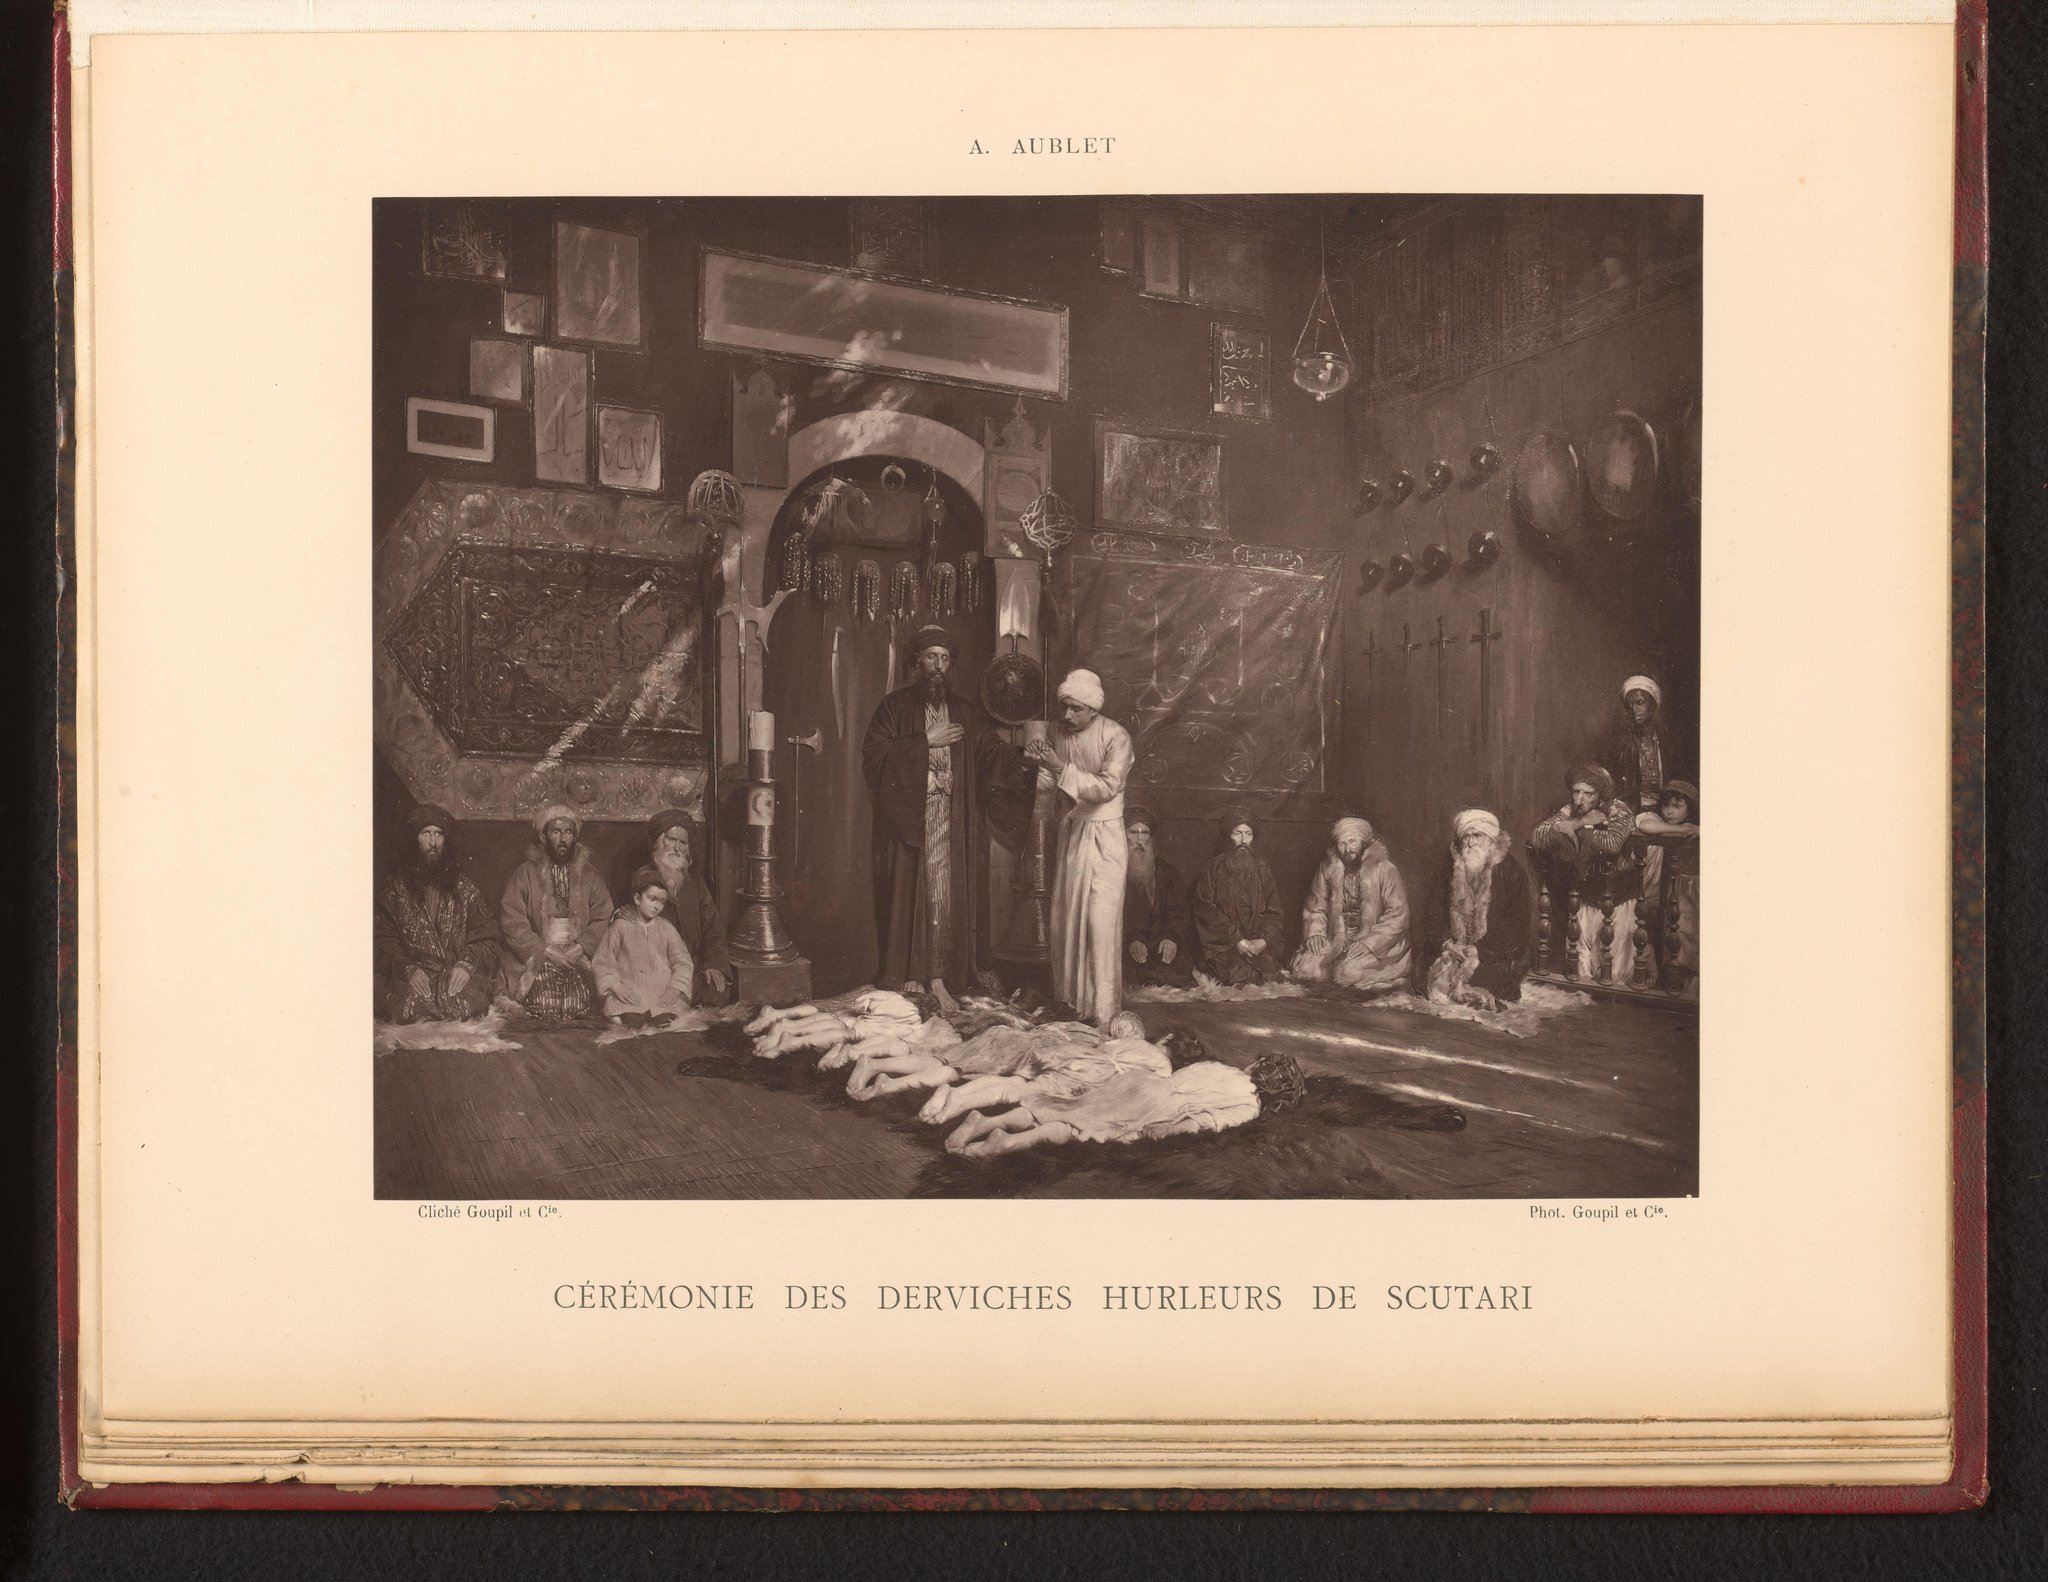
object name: photomechanical print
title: Cérémonie des derviches hurleurs de Scutari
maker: albert louis aublet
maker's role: painter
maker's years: 1851-1938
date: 1877-1882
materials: paper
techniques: woodburytype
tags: ritual practices ~ islam, mohammedanism